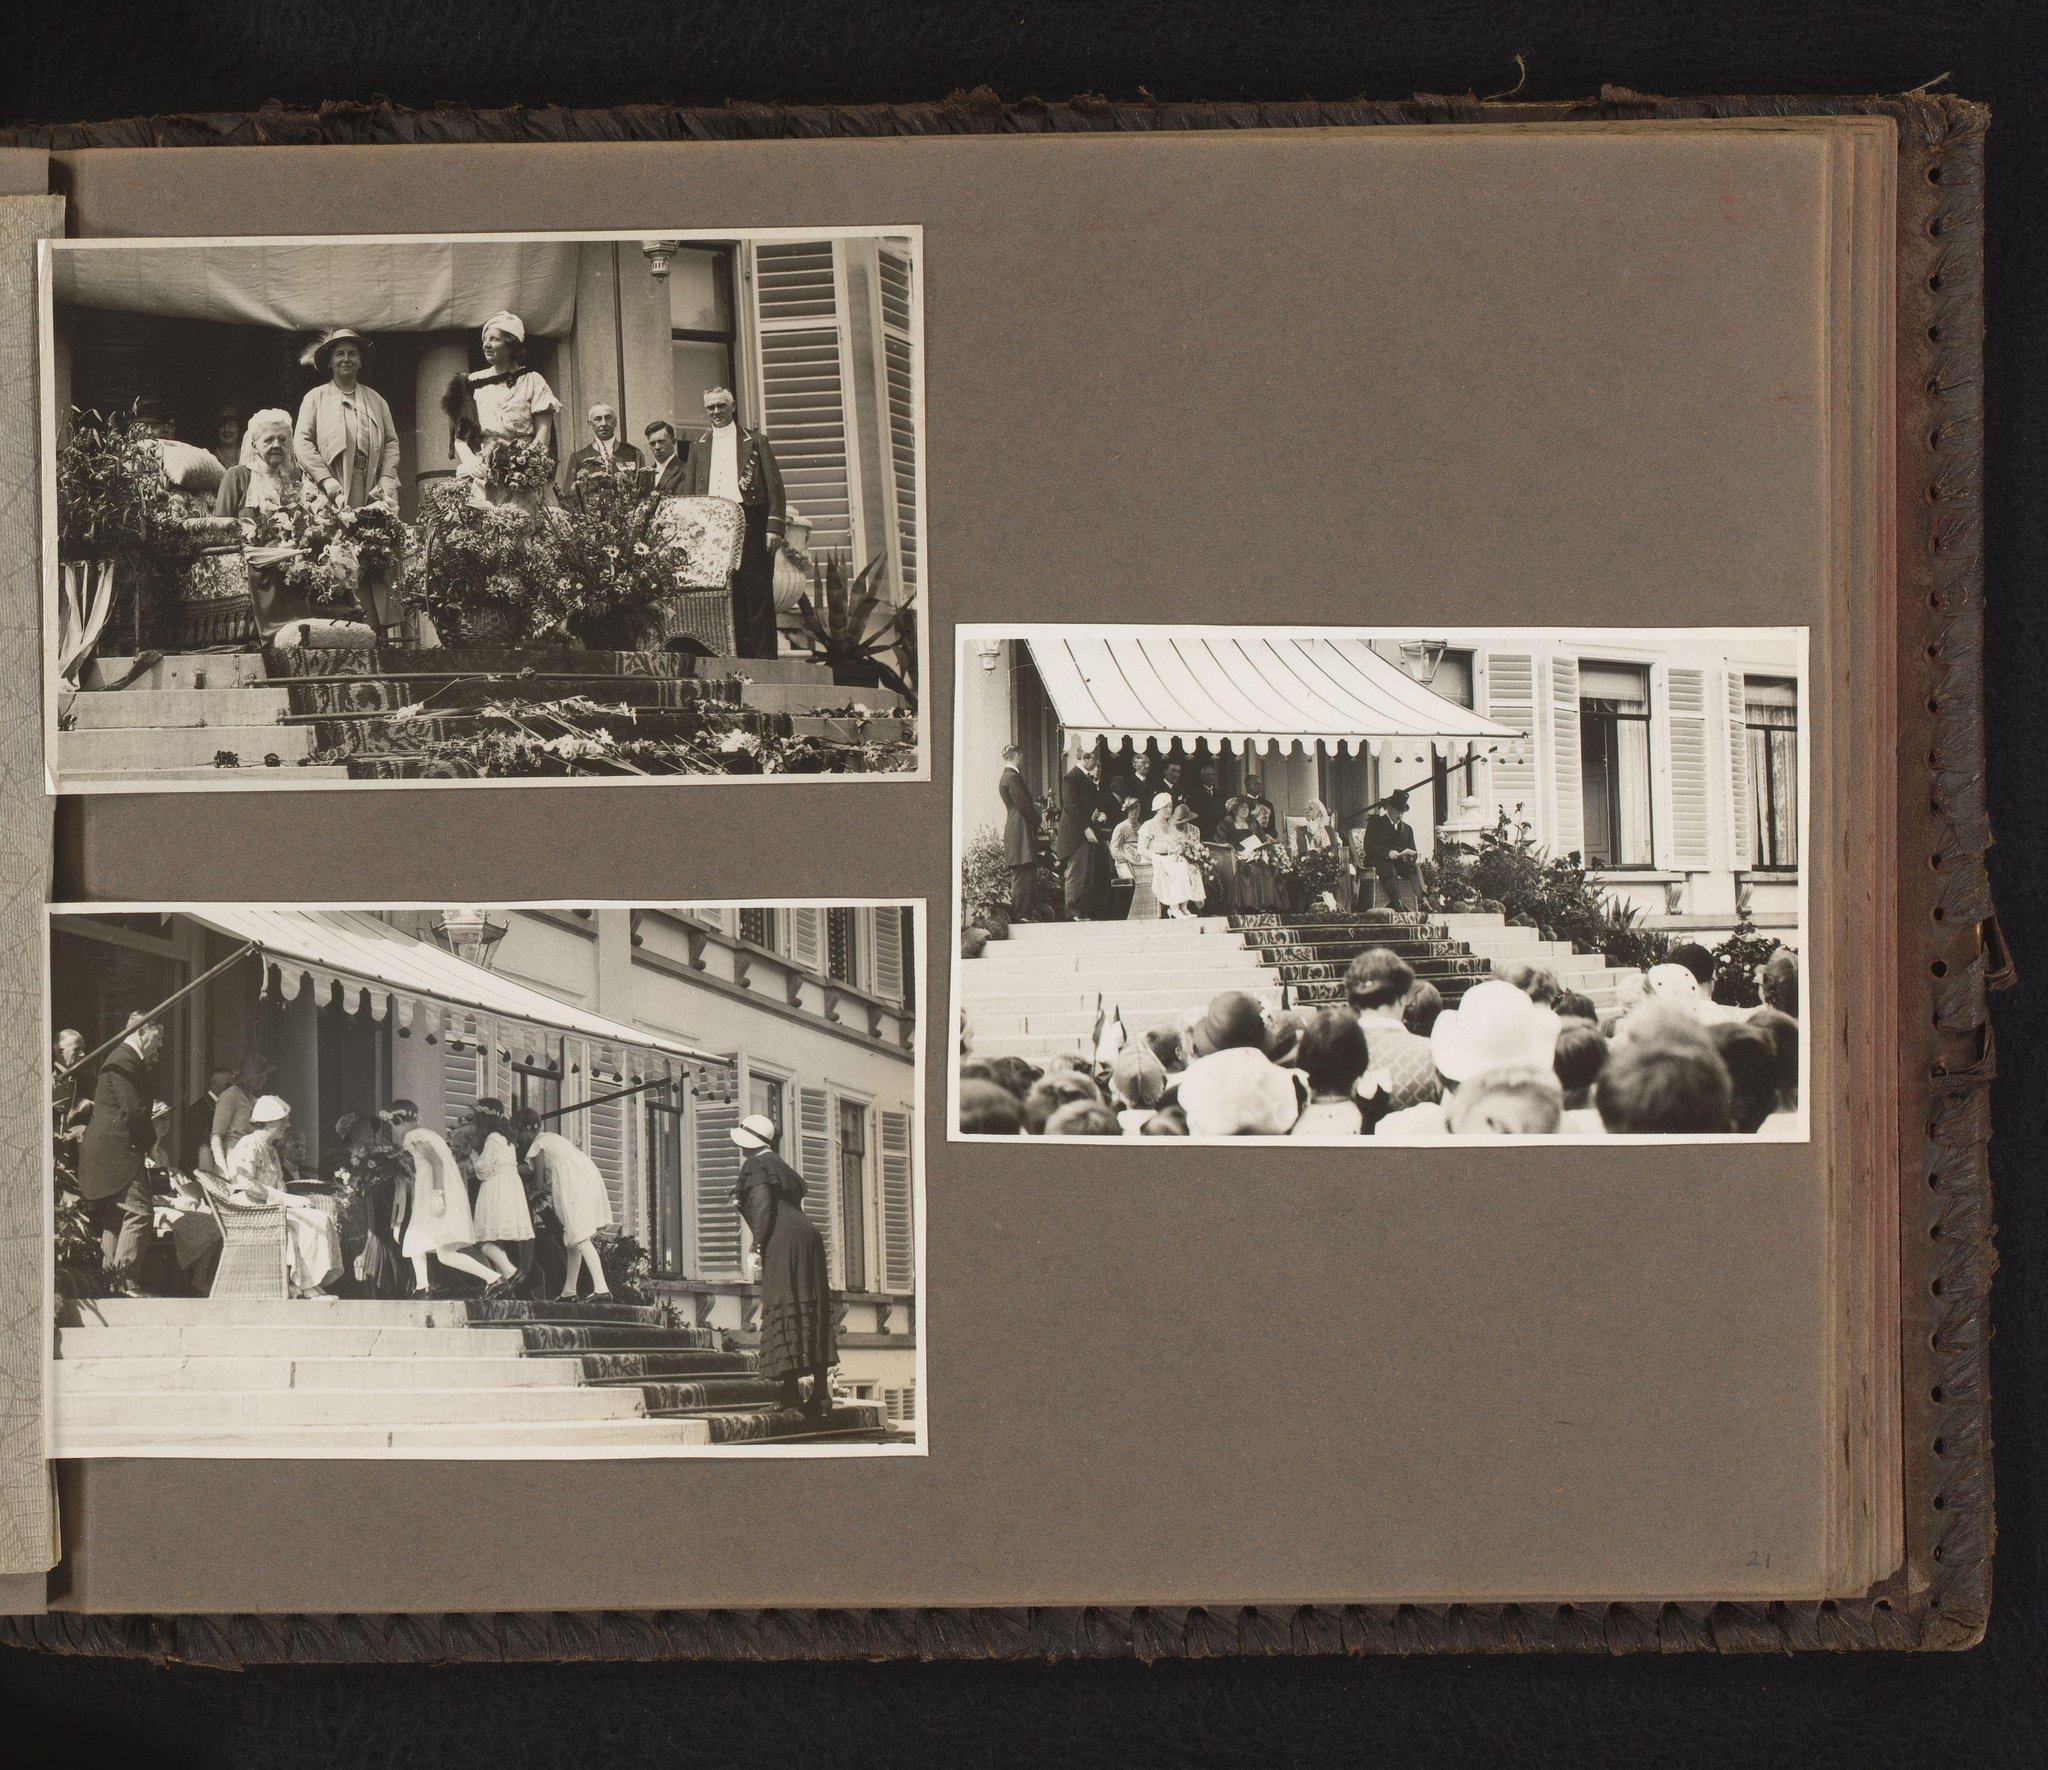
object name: album leaf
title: Drie foto's van prinses Juliana, koningin Wilhelmina en koningin-moeder Emma op paleis Soestdijk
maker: Anonymous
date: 1930-1934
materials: paper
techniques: gelatin silver print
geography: soestdijk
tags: the hague, print maker, wilhelmina of the netherlands, emma (queen consort of the netherlands), juliana of the netherlands, adult woman, family of a ruler, and court - bb - female ruler, old woman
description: Deze foto's maken deel uit van een album.